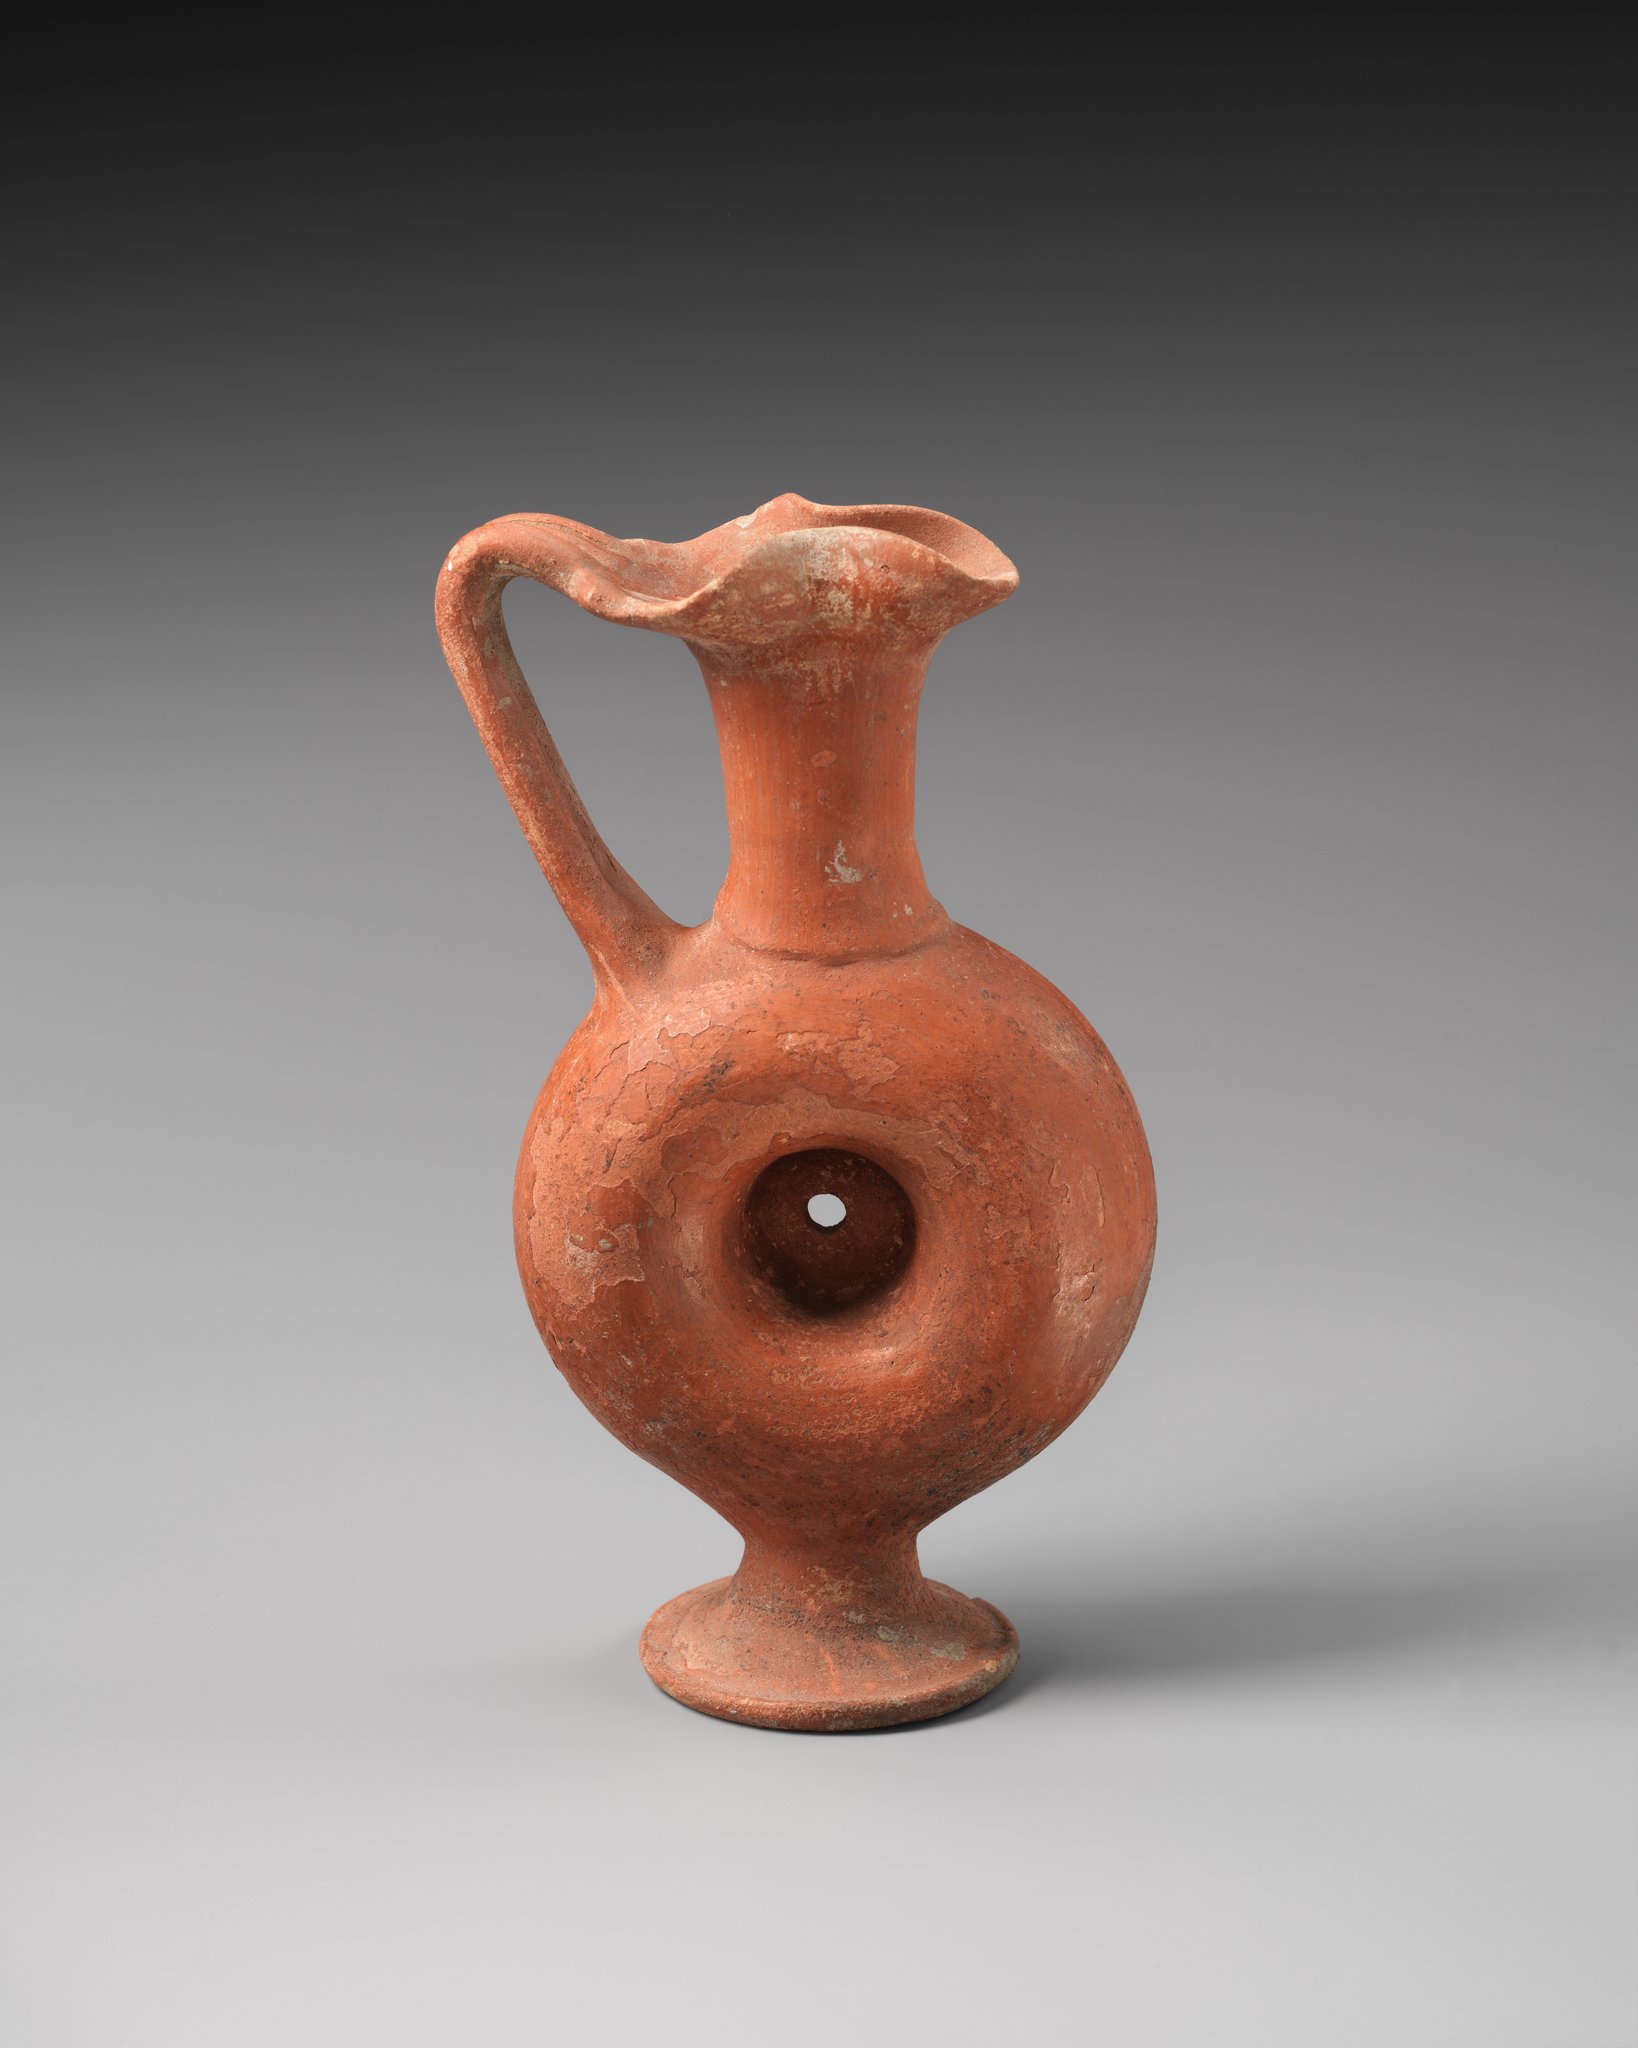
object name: ring vase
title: Terracotta ring vase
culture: phoenician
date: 700-601 BCE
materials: terracotta